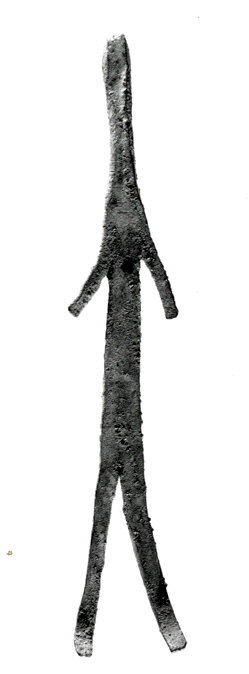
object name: figure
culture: middle niger civilization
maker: middle niger artist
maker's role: artist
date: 801-1700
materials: copper alloy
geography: mali